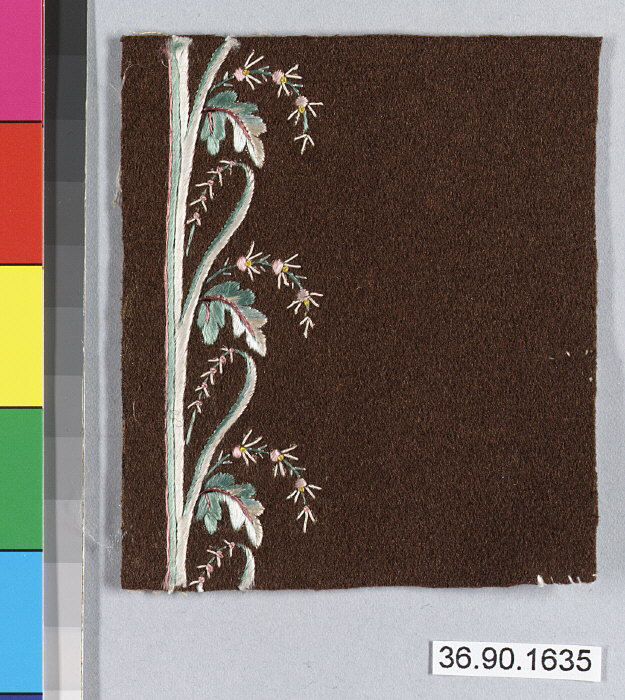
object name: sample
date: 1801-1833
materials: felt, silk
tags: plants